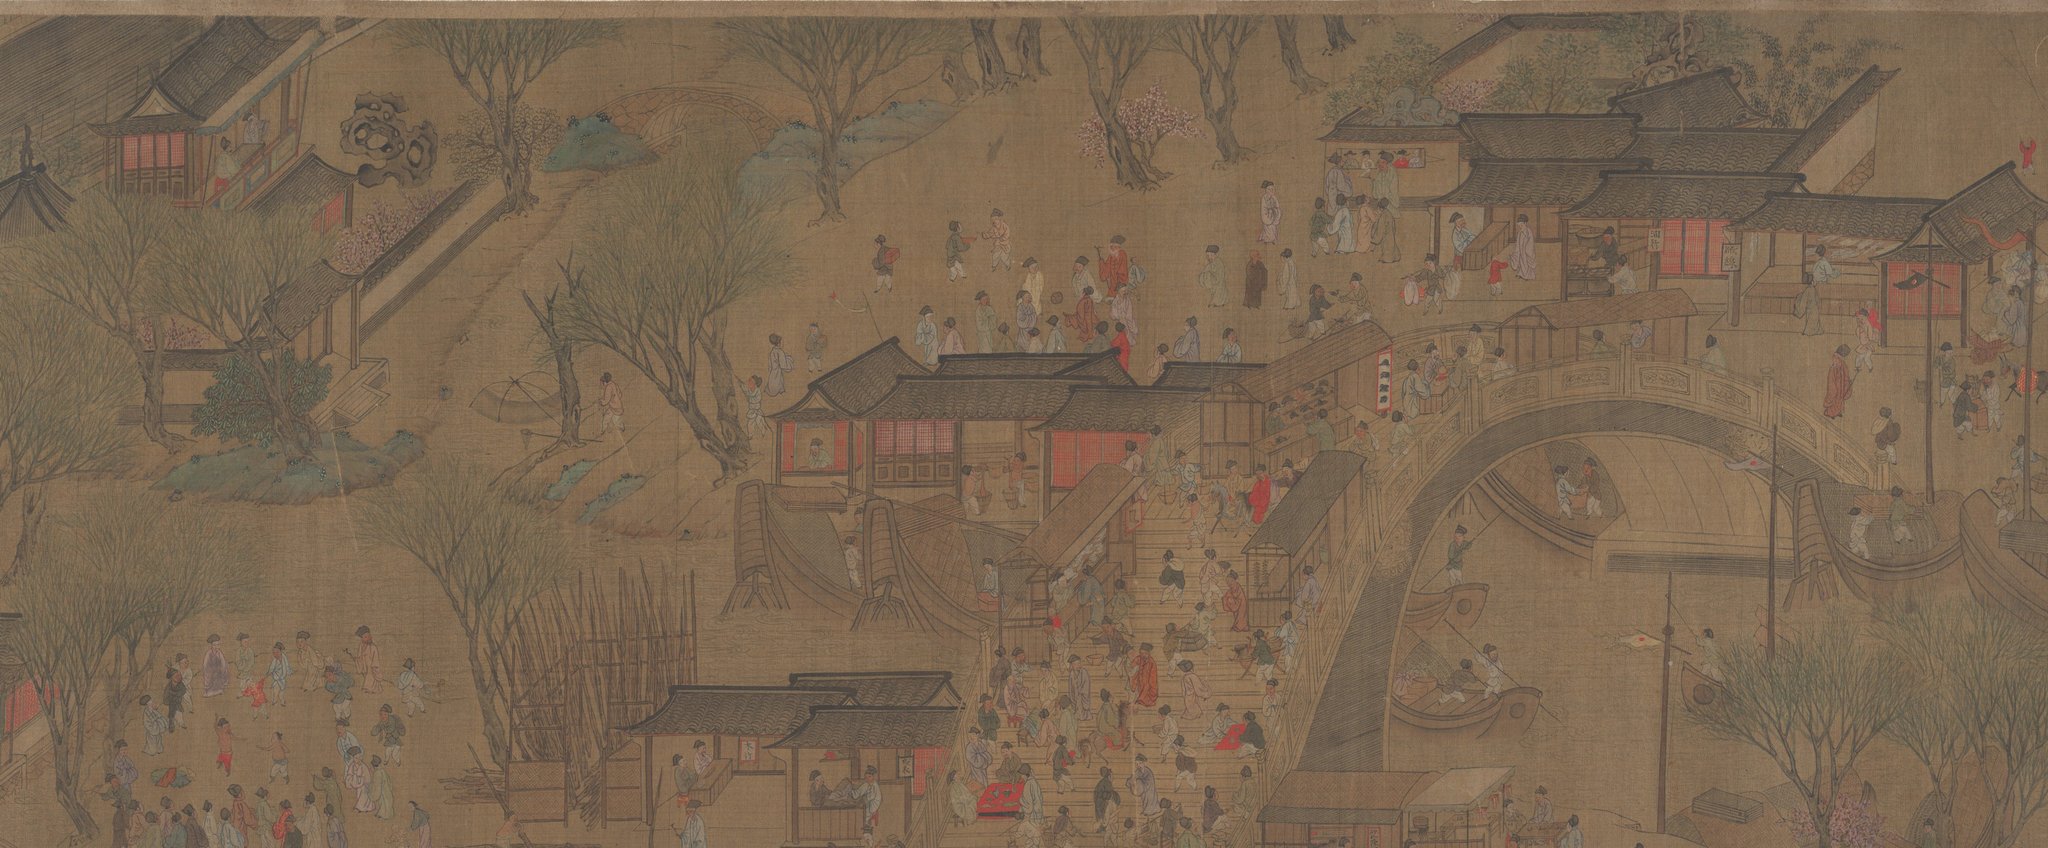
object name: handscroll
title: Going Upriver on the Qingming Festival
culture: chinese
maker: unidentified artist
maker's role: artist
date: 1644-1911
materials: ink, silk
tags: human figures,bridges,rivers,boats